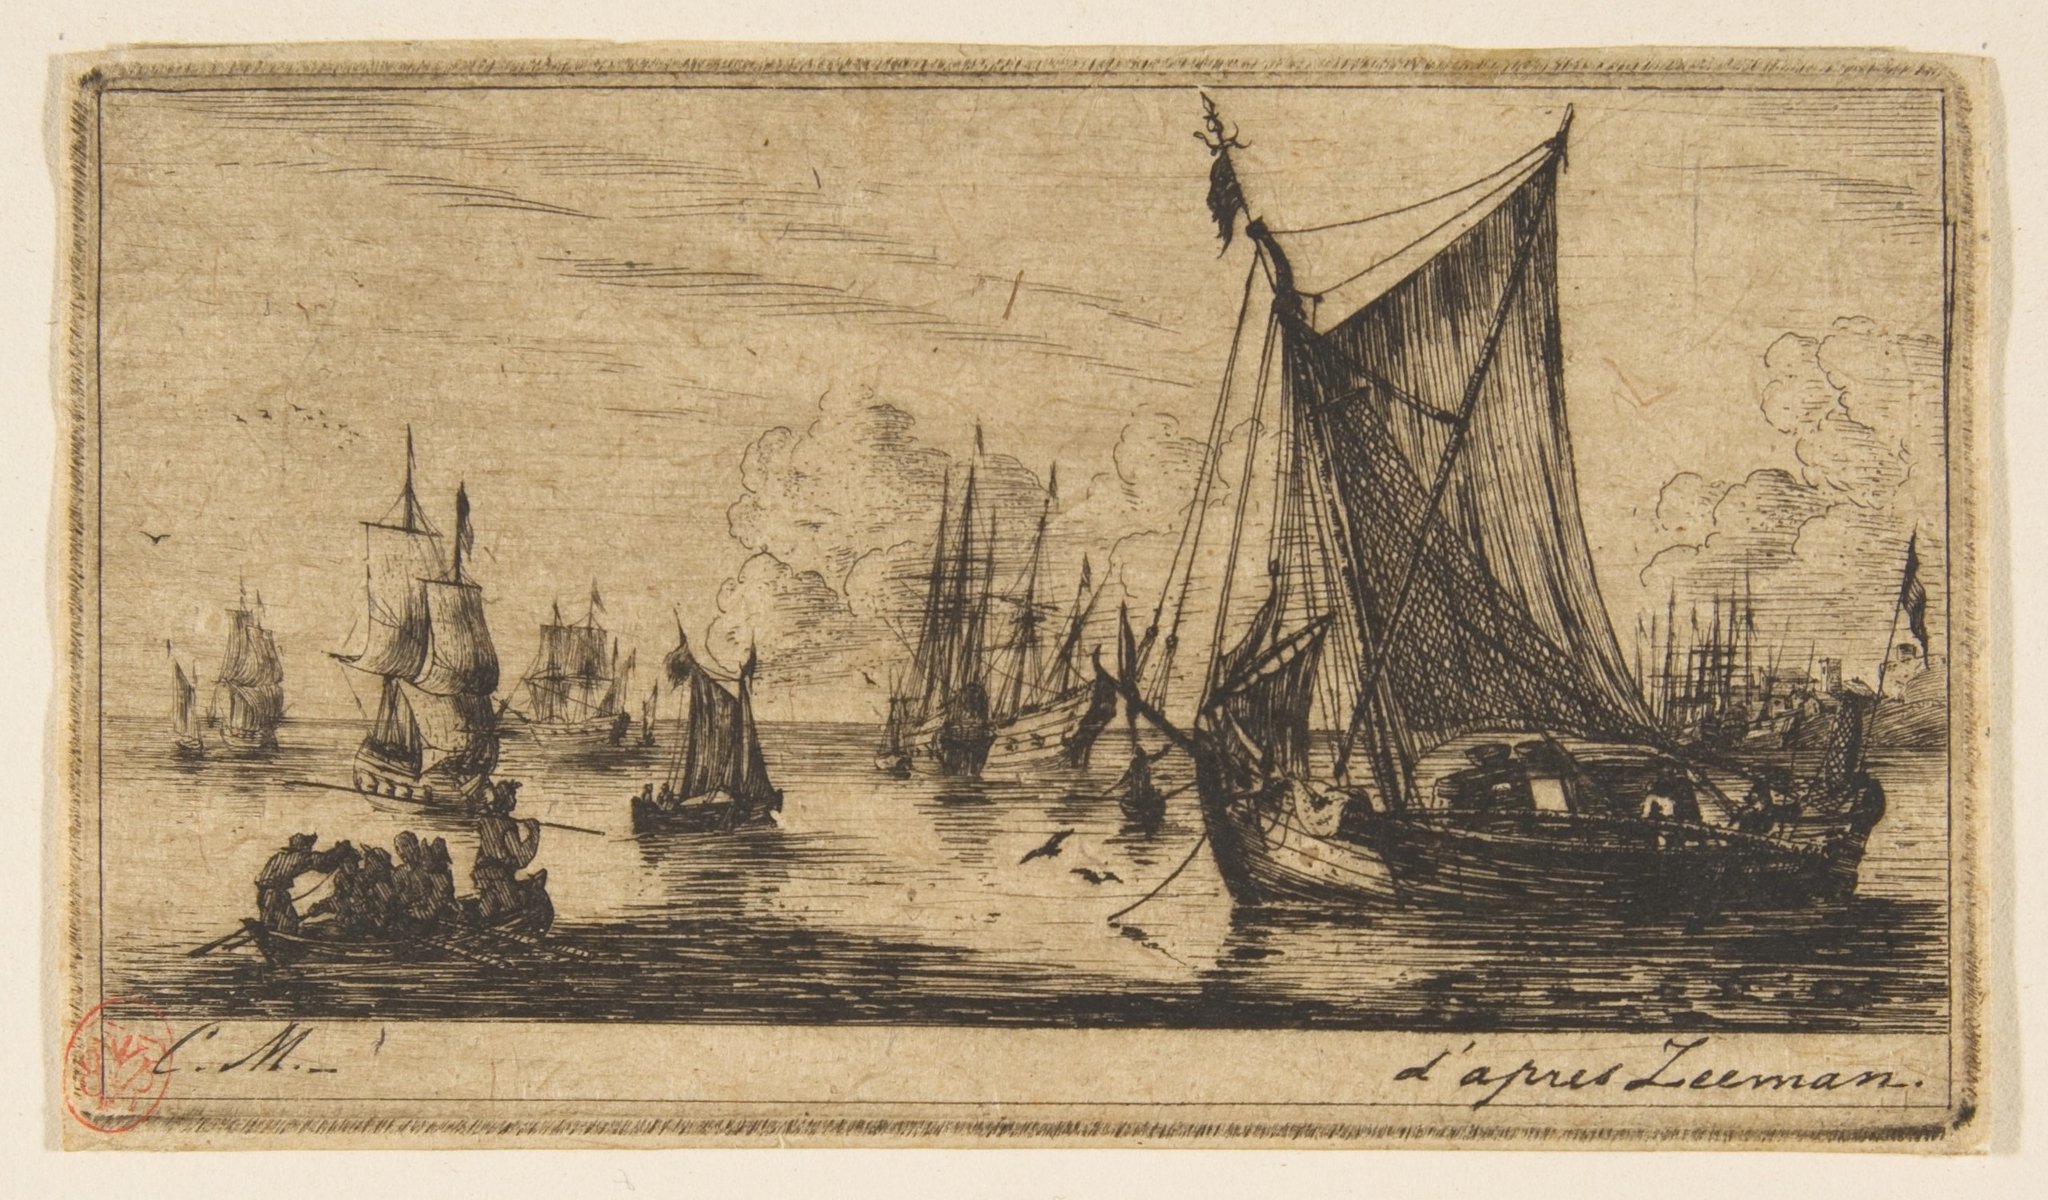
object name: print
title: South Sea Fishers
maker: charles meryon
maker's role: artist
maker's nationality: french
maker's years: 1821-1868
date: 1850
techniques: etching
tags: ships